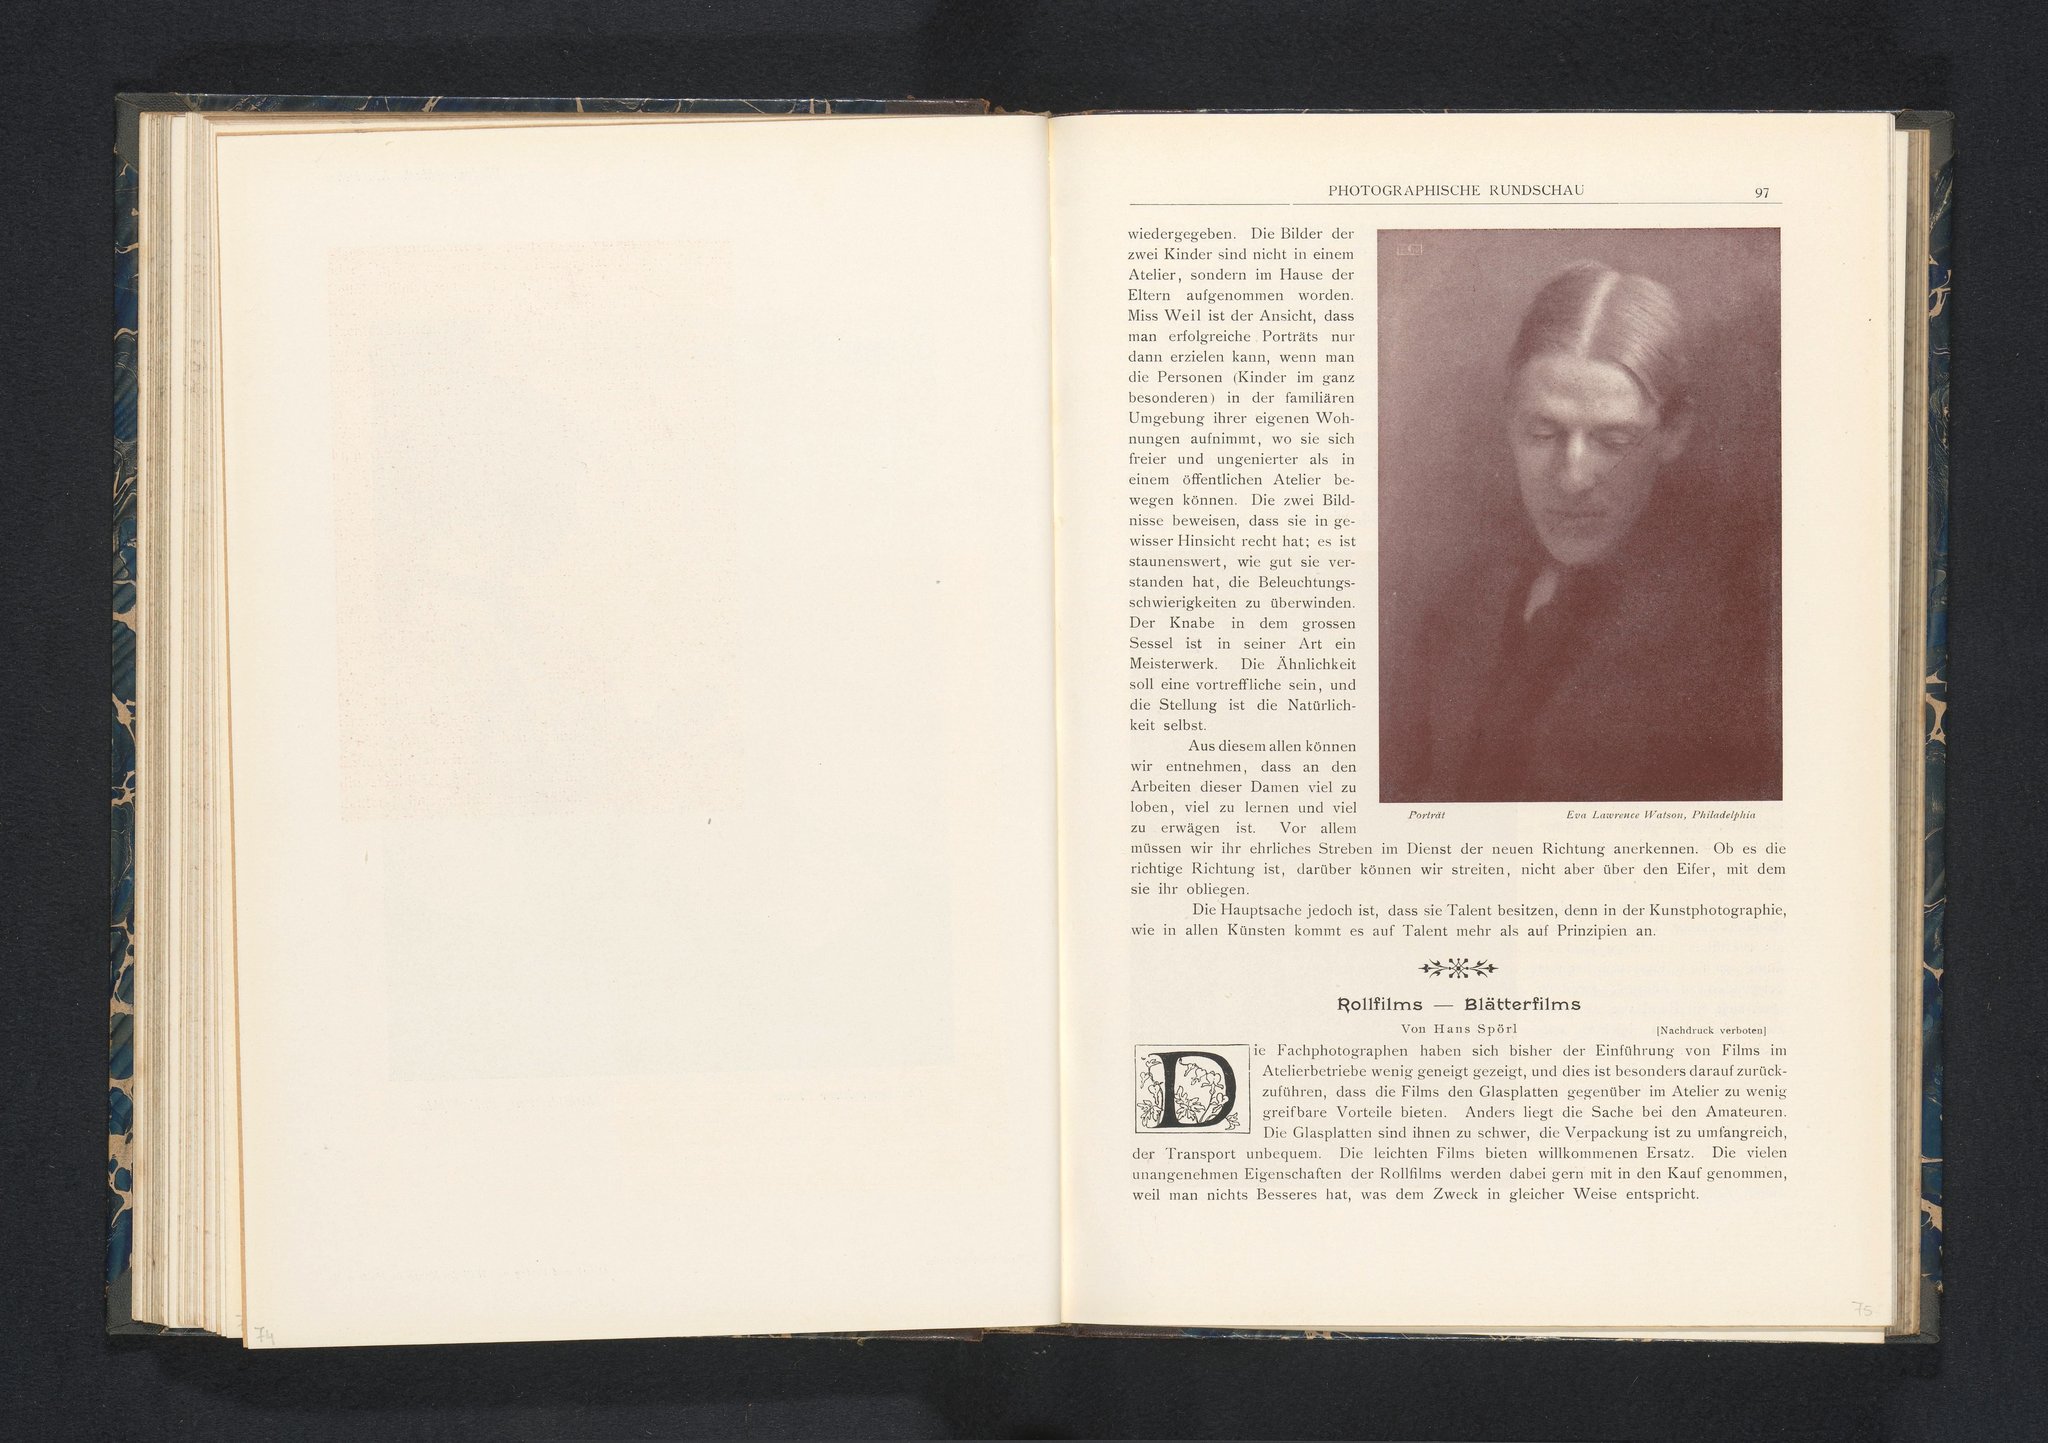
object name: photomechanical print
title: Portret van een onbekende vrouw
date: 1896-1901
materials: paper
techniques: autotype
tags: historical persons not known by name - bb - woman